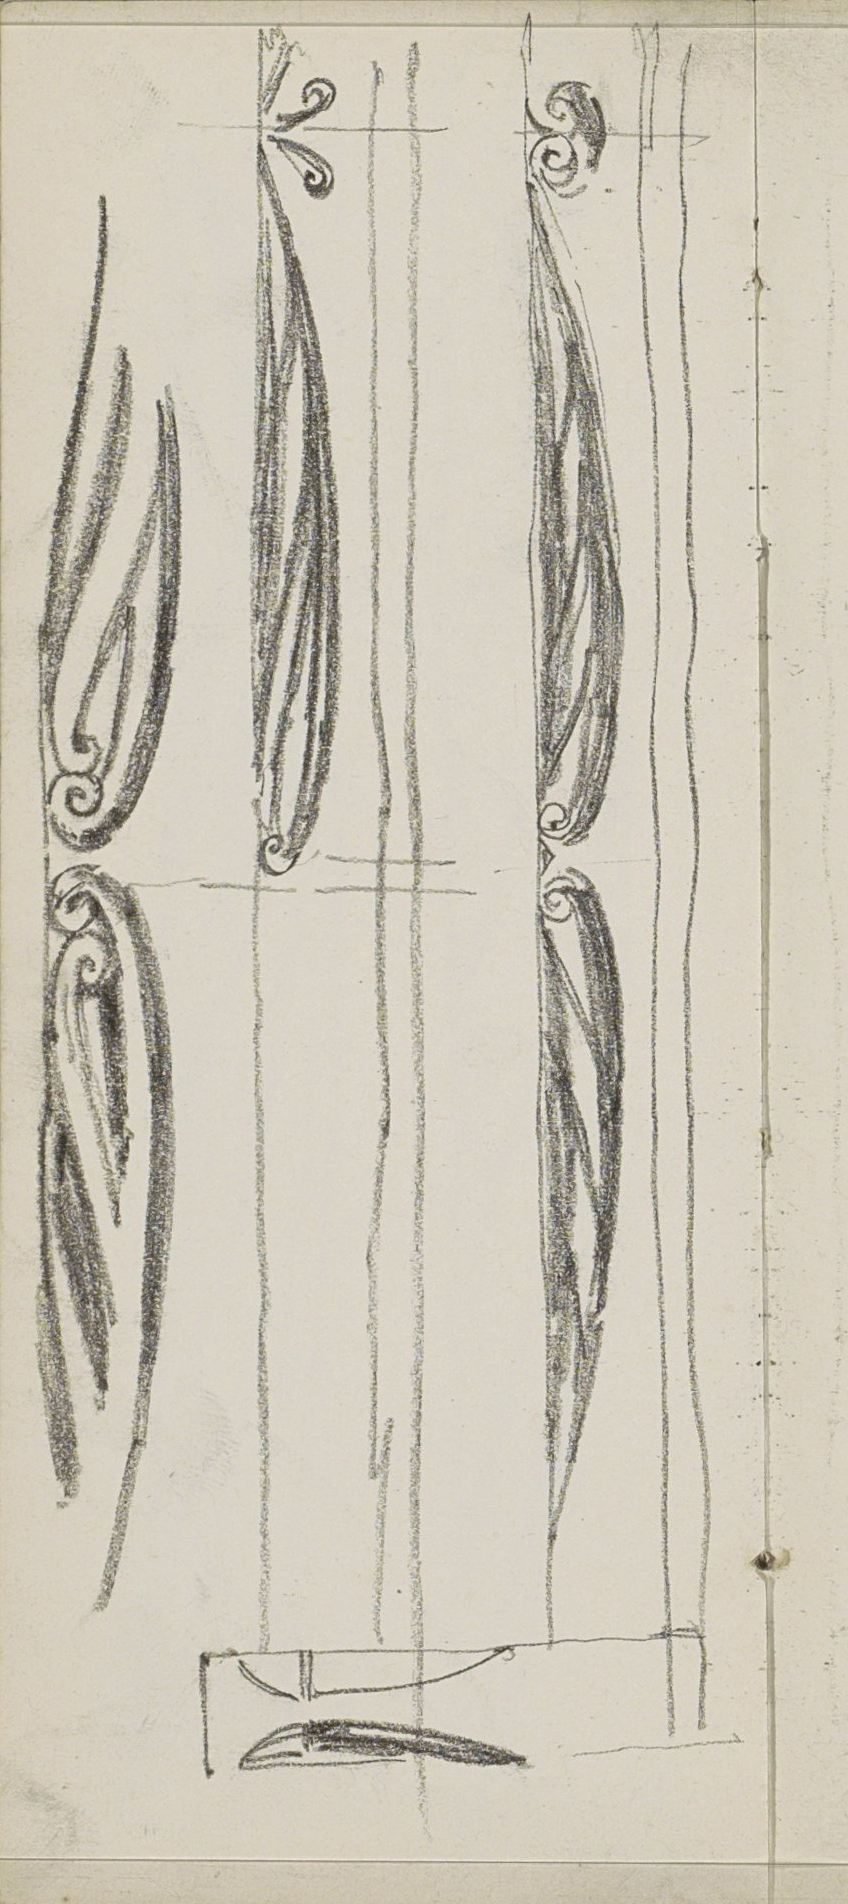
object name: sketchbook leaf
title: Ornamenten met rolwerk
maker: gerrit willem dijsselhof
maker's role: designer, draughtsman, print maker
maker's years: 1866-1924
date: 1876-1924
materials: chalk, paper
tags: ribbon, scroll, banderole ~ ornament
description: Mogelijk gevelversieringen. Blad 19 verso uit een schetsboek met 40 bladen.